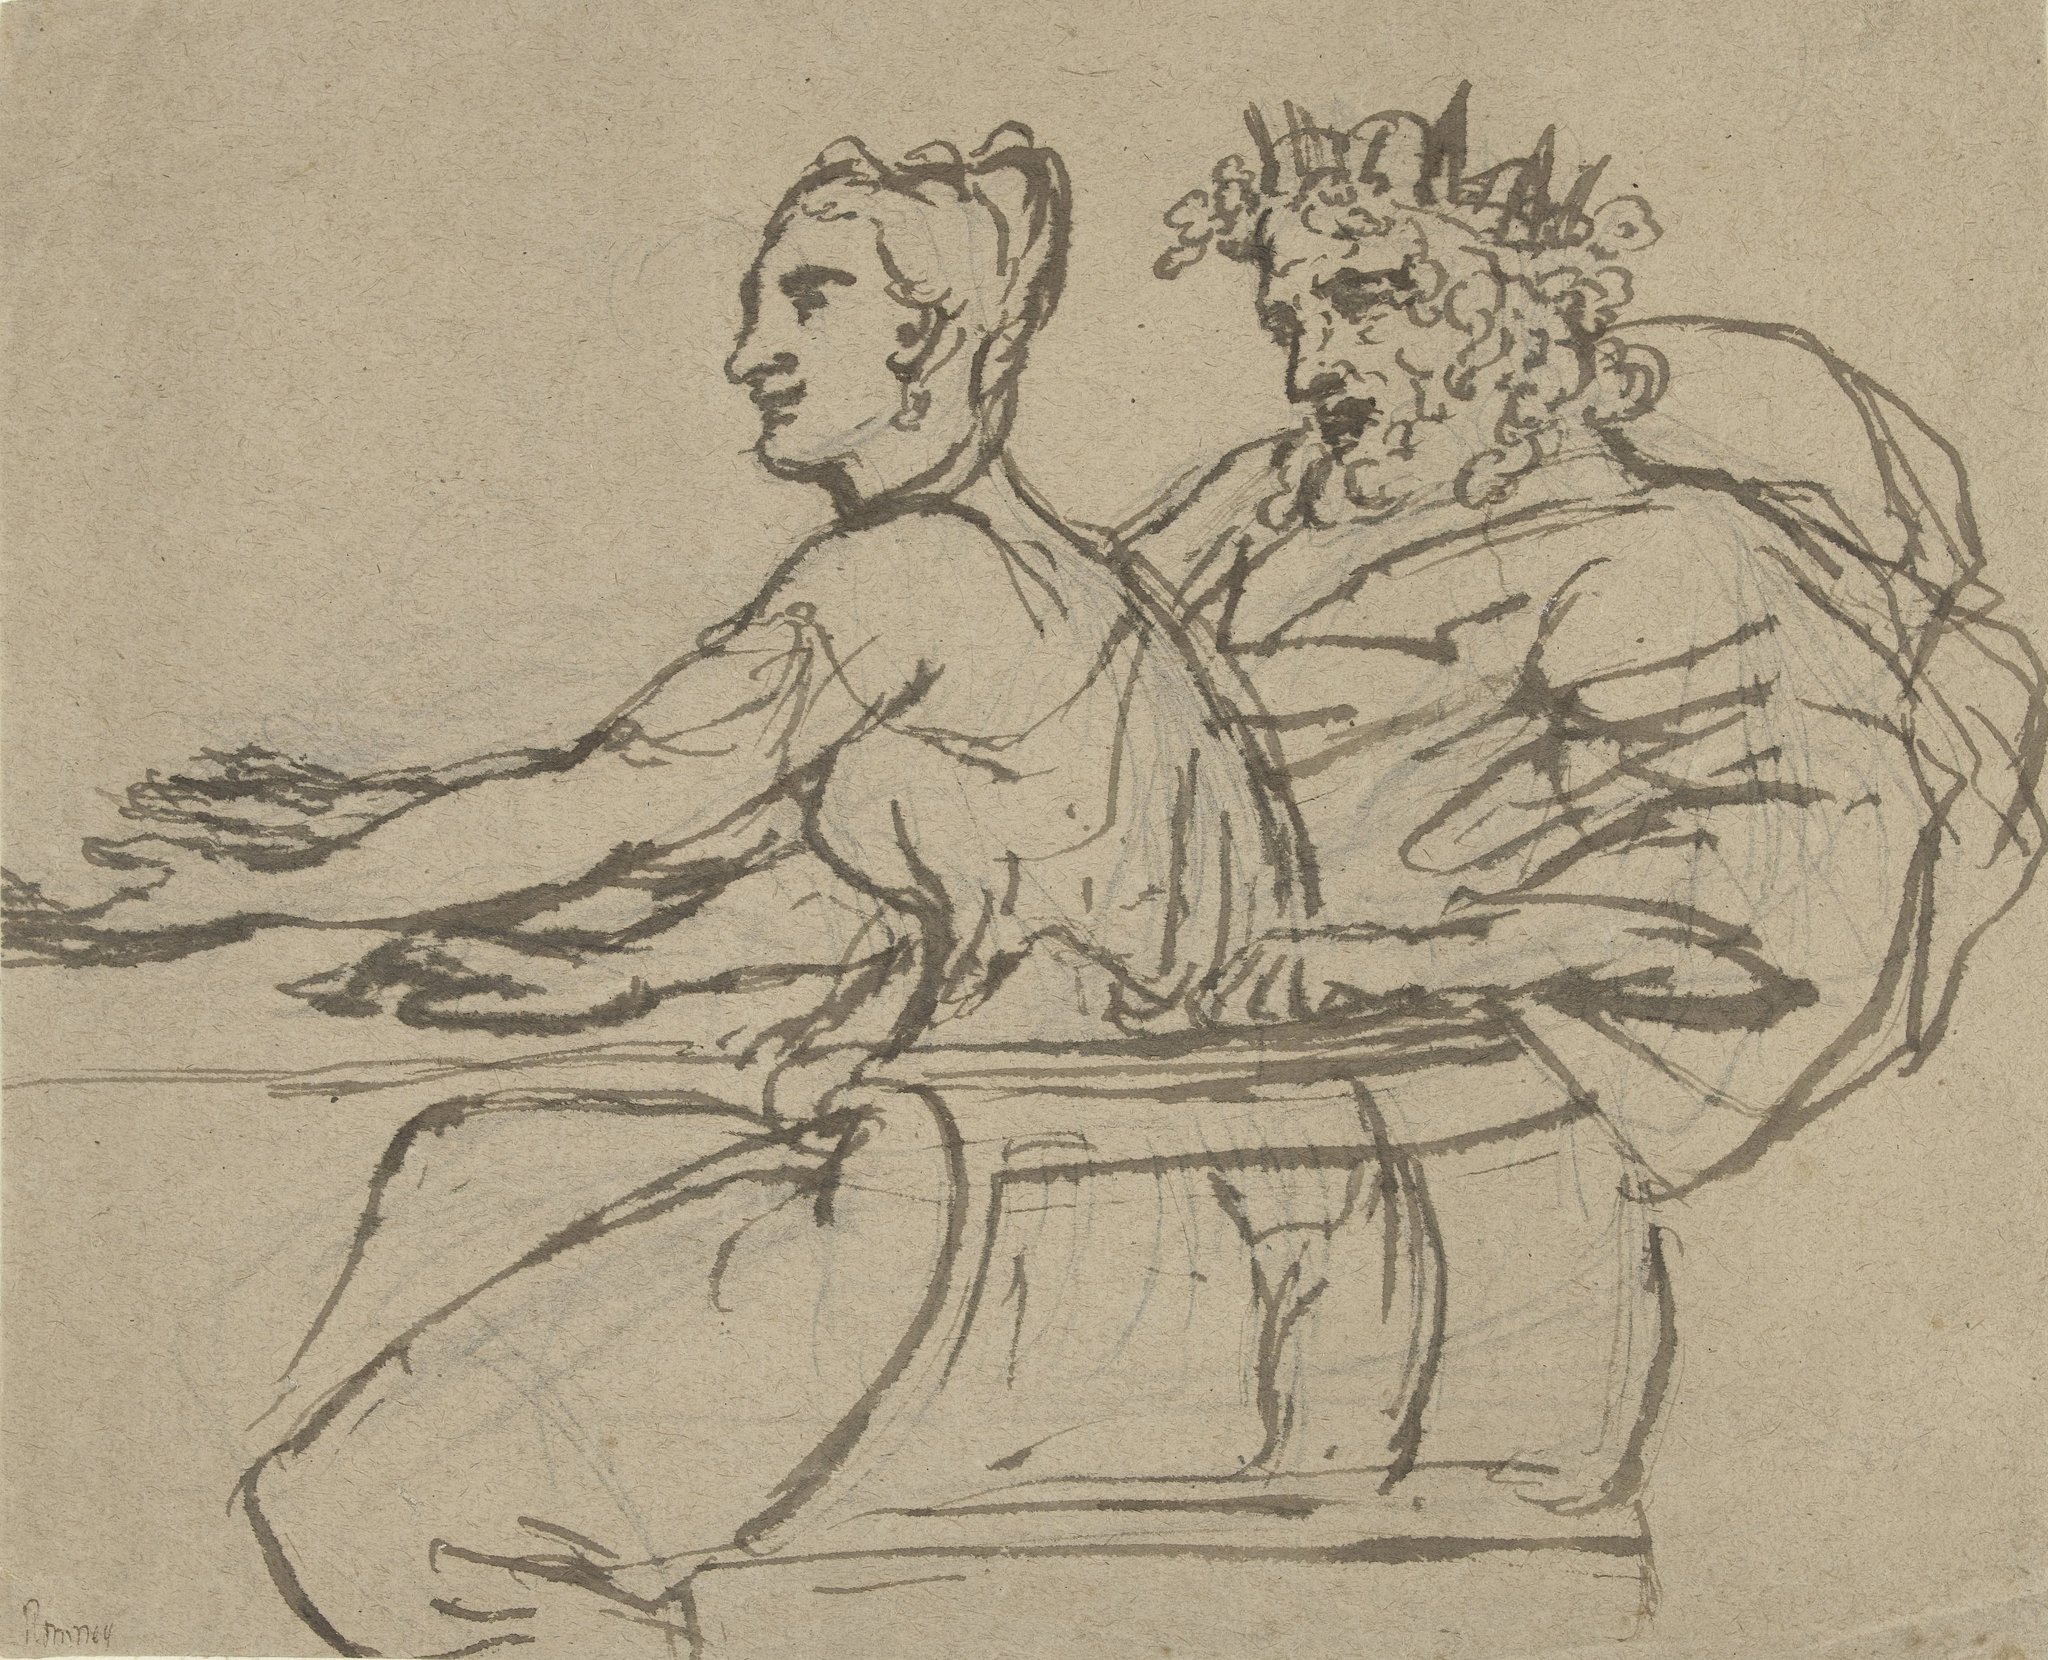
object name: drawing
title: Een koning en een jonge vrouw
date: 1744-1816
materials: ink, paper, pencil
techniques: pen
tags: salome is given the head of john the baptist by the executioner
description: Een koning met aan zijn linkerhand een jonge vrouw gezeten op een bank met leuning, van ter zijde gezien Herodes en Salome.